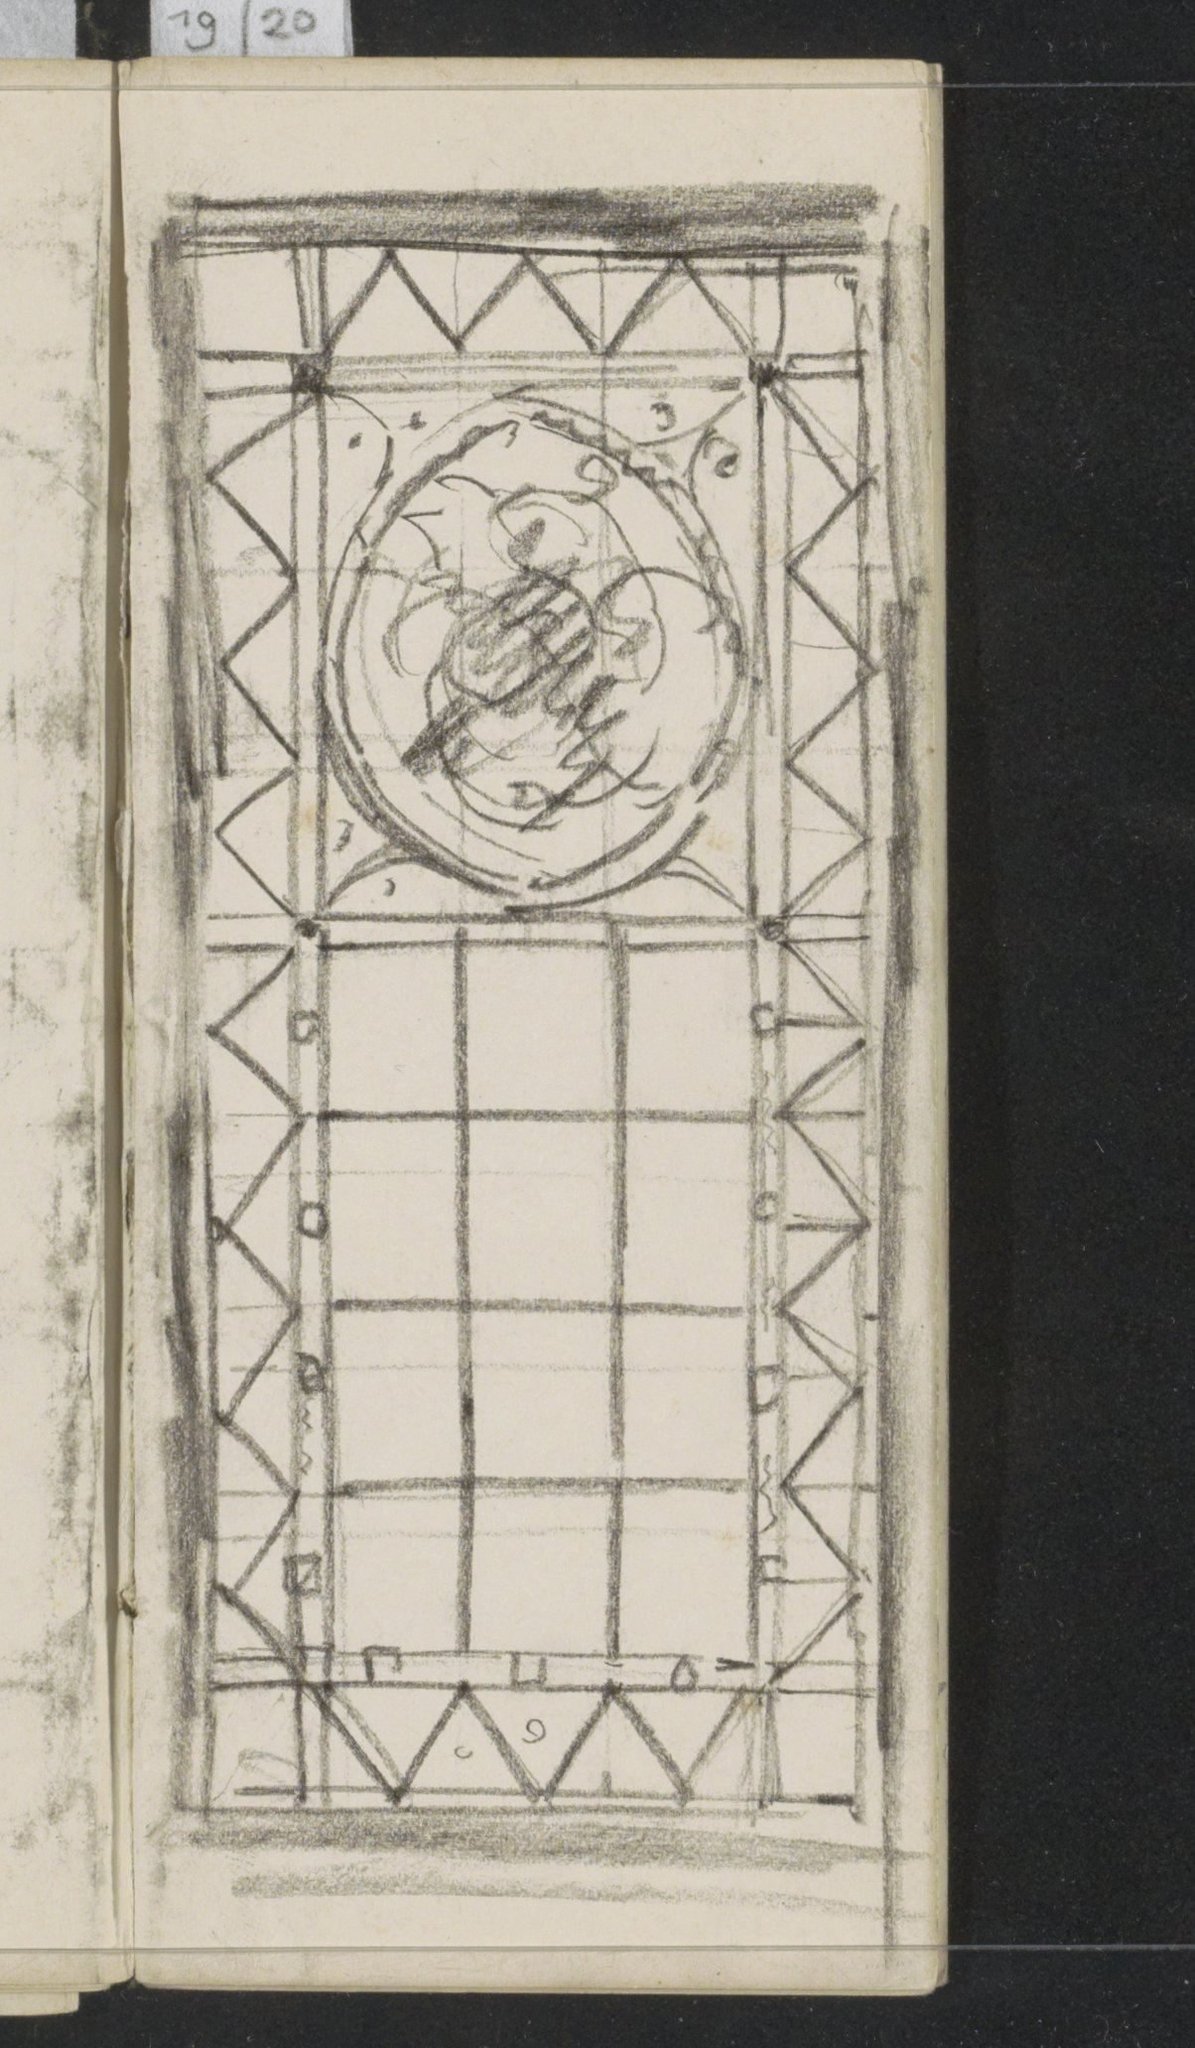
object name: sketchbook leaf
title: Ontwerp voor een glas-in-loodvenster met een vogel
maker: gerrit willem dijsselhof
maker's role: designer, draughtsman, print maker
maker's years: 1866-1924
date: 1876-1924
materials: chalk, paper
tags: window, birds, work of applied art (+ types of art)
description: Blad 16 recto uit een schetsboek met 24 bladen.